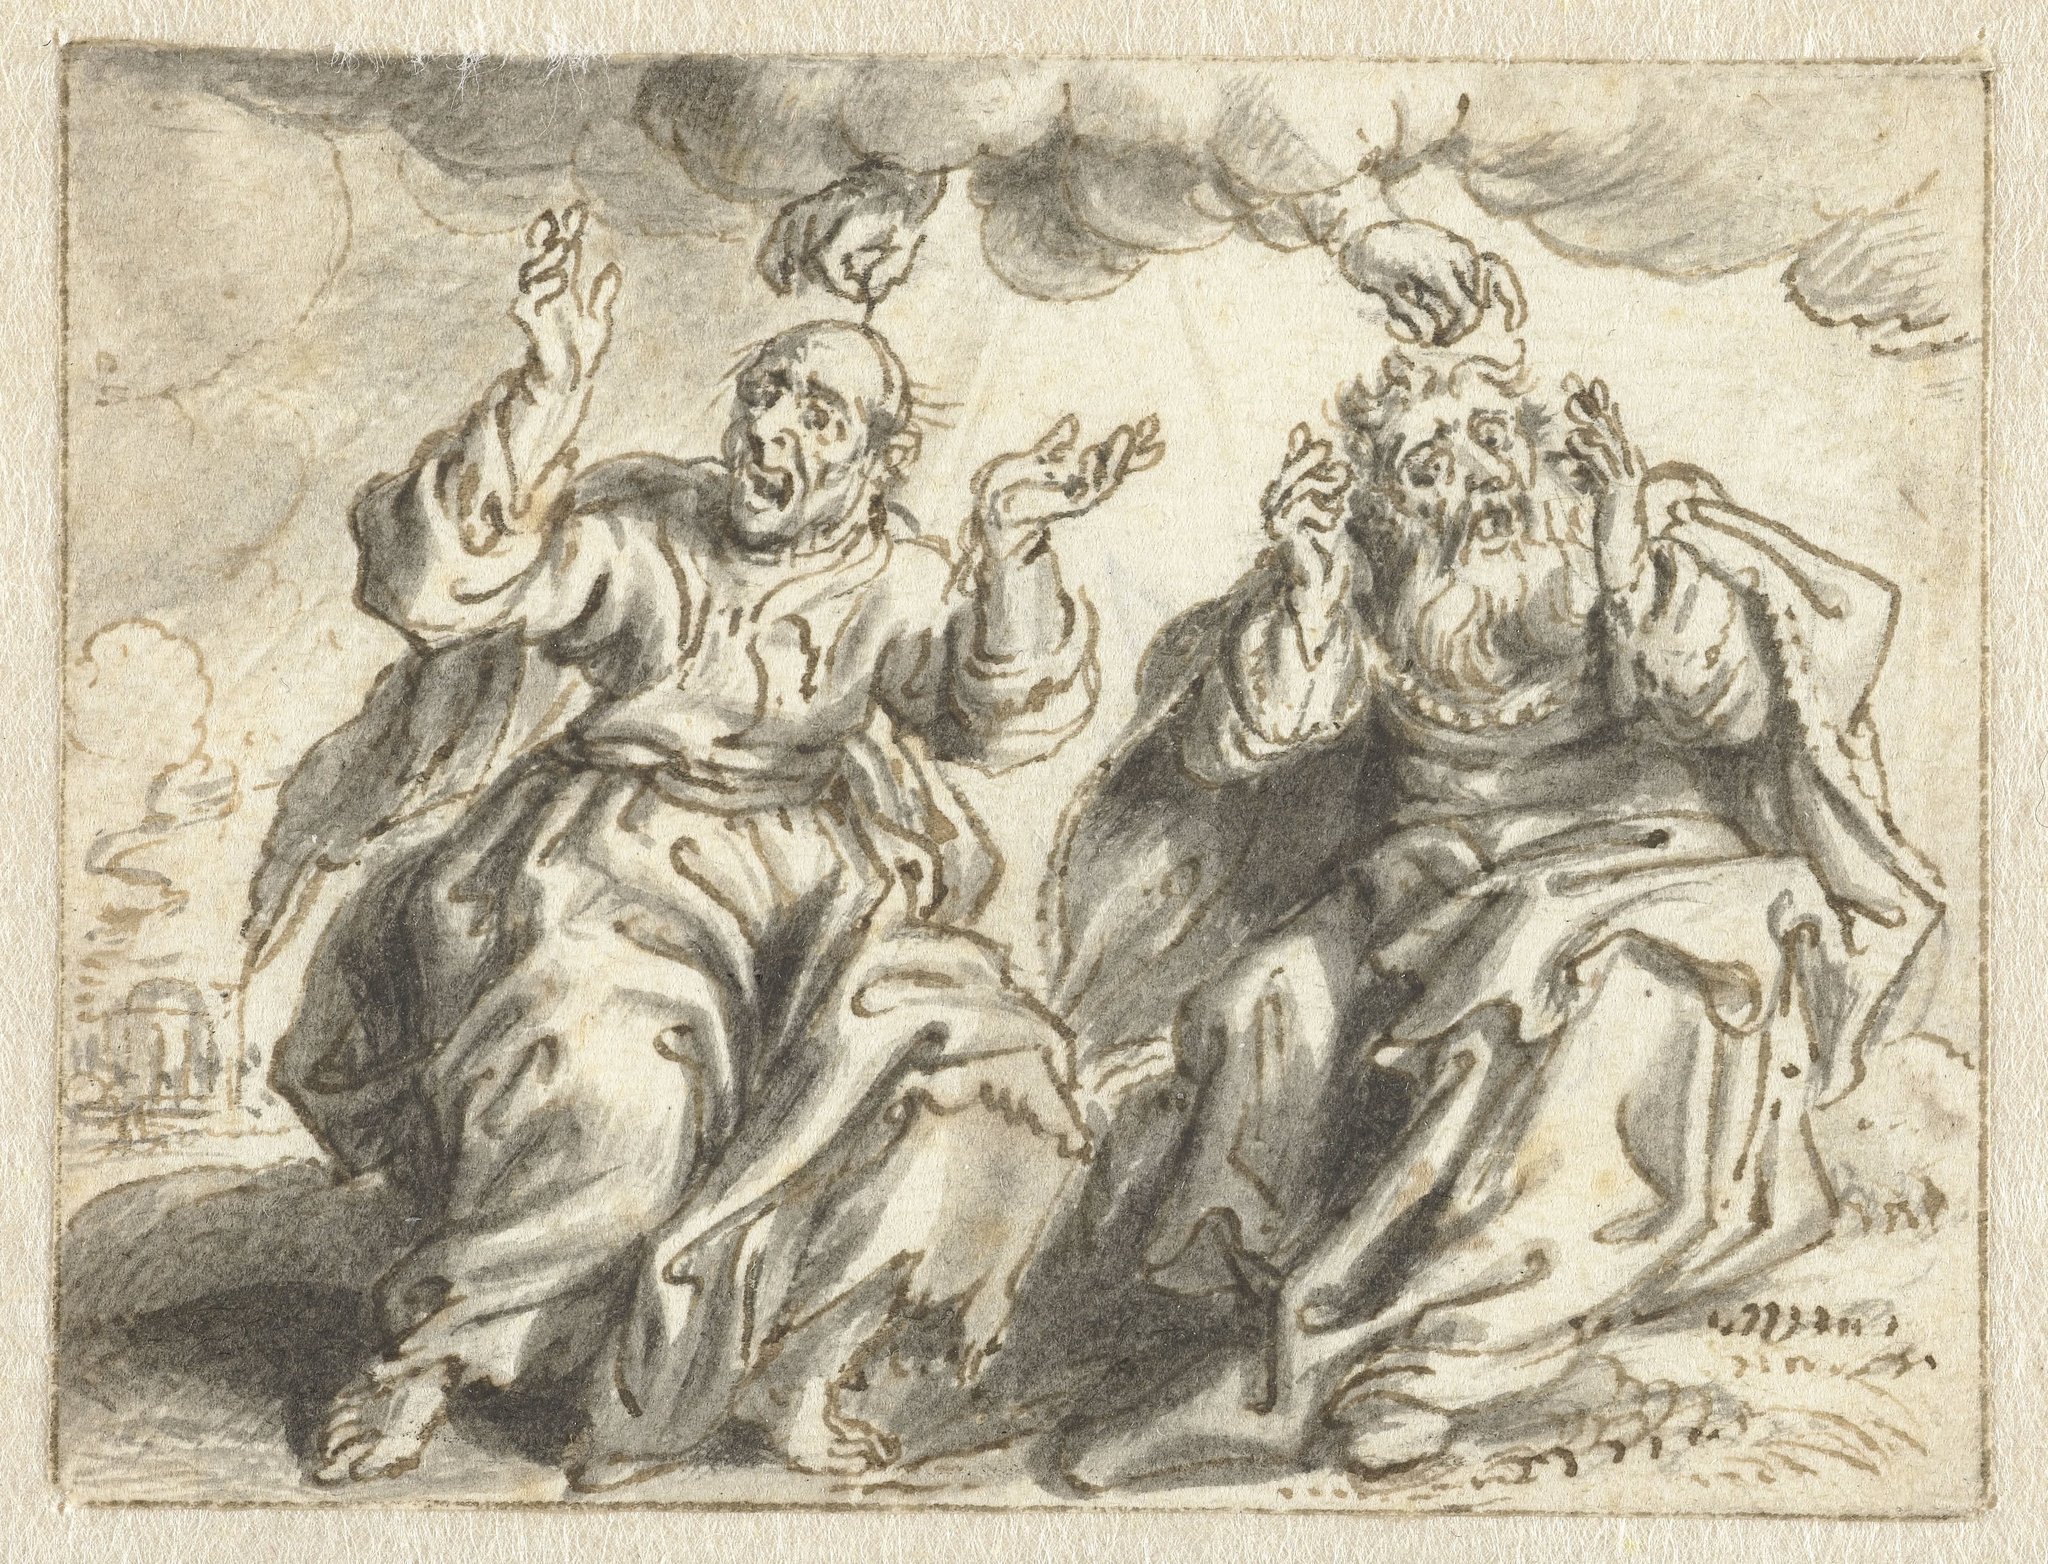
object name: drawing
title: Hands Emerging from a Cloud, Plucking Hairs from the Heads of Two Elderly Men, One almost Bald, the Other with a Luxuriant Thatch of Hair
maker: adriaen pietersz van de venne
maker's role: draughtsman, painter, print maker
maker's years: 1589-1662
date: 1633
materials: chalk, paint, ink, paper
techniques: brush, pen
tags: sitting figure